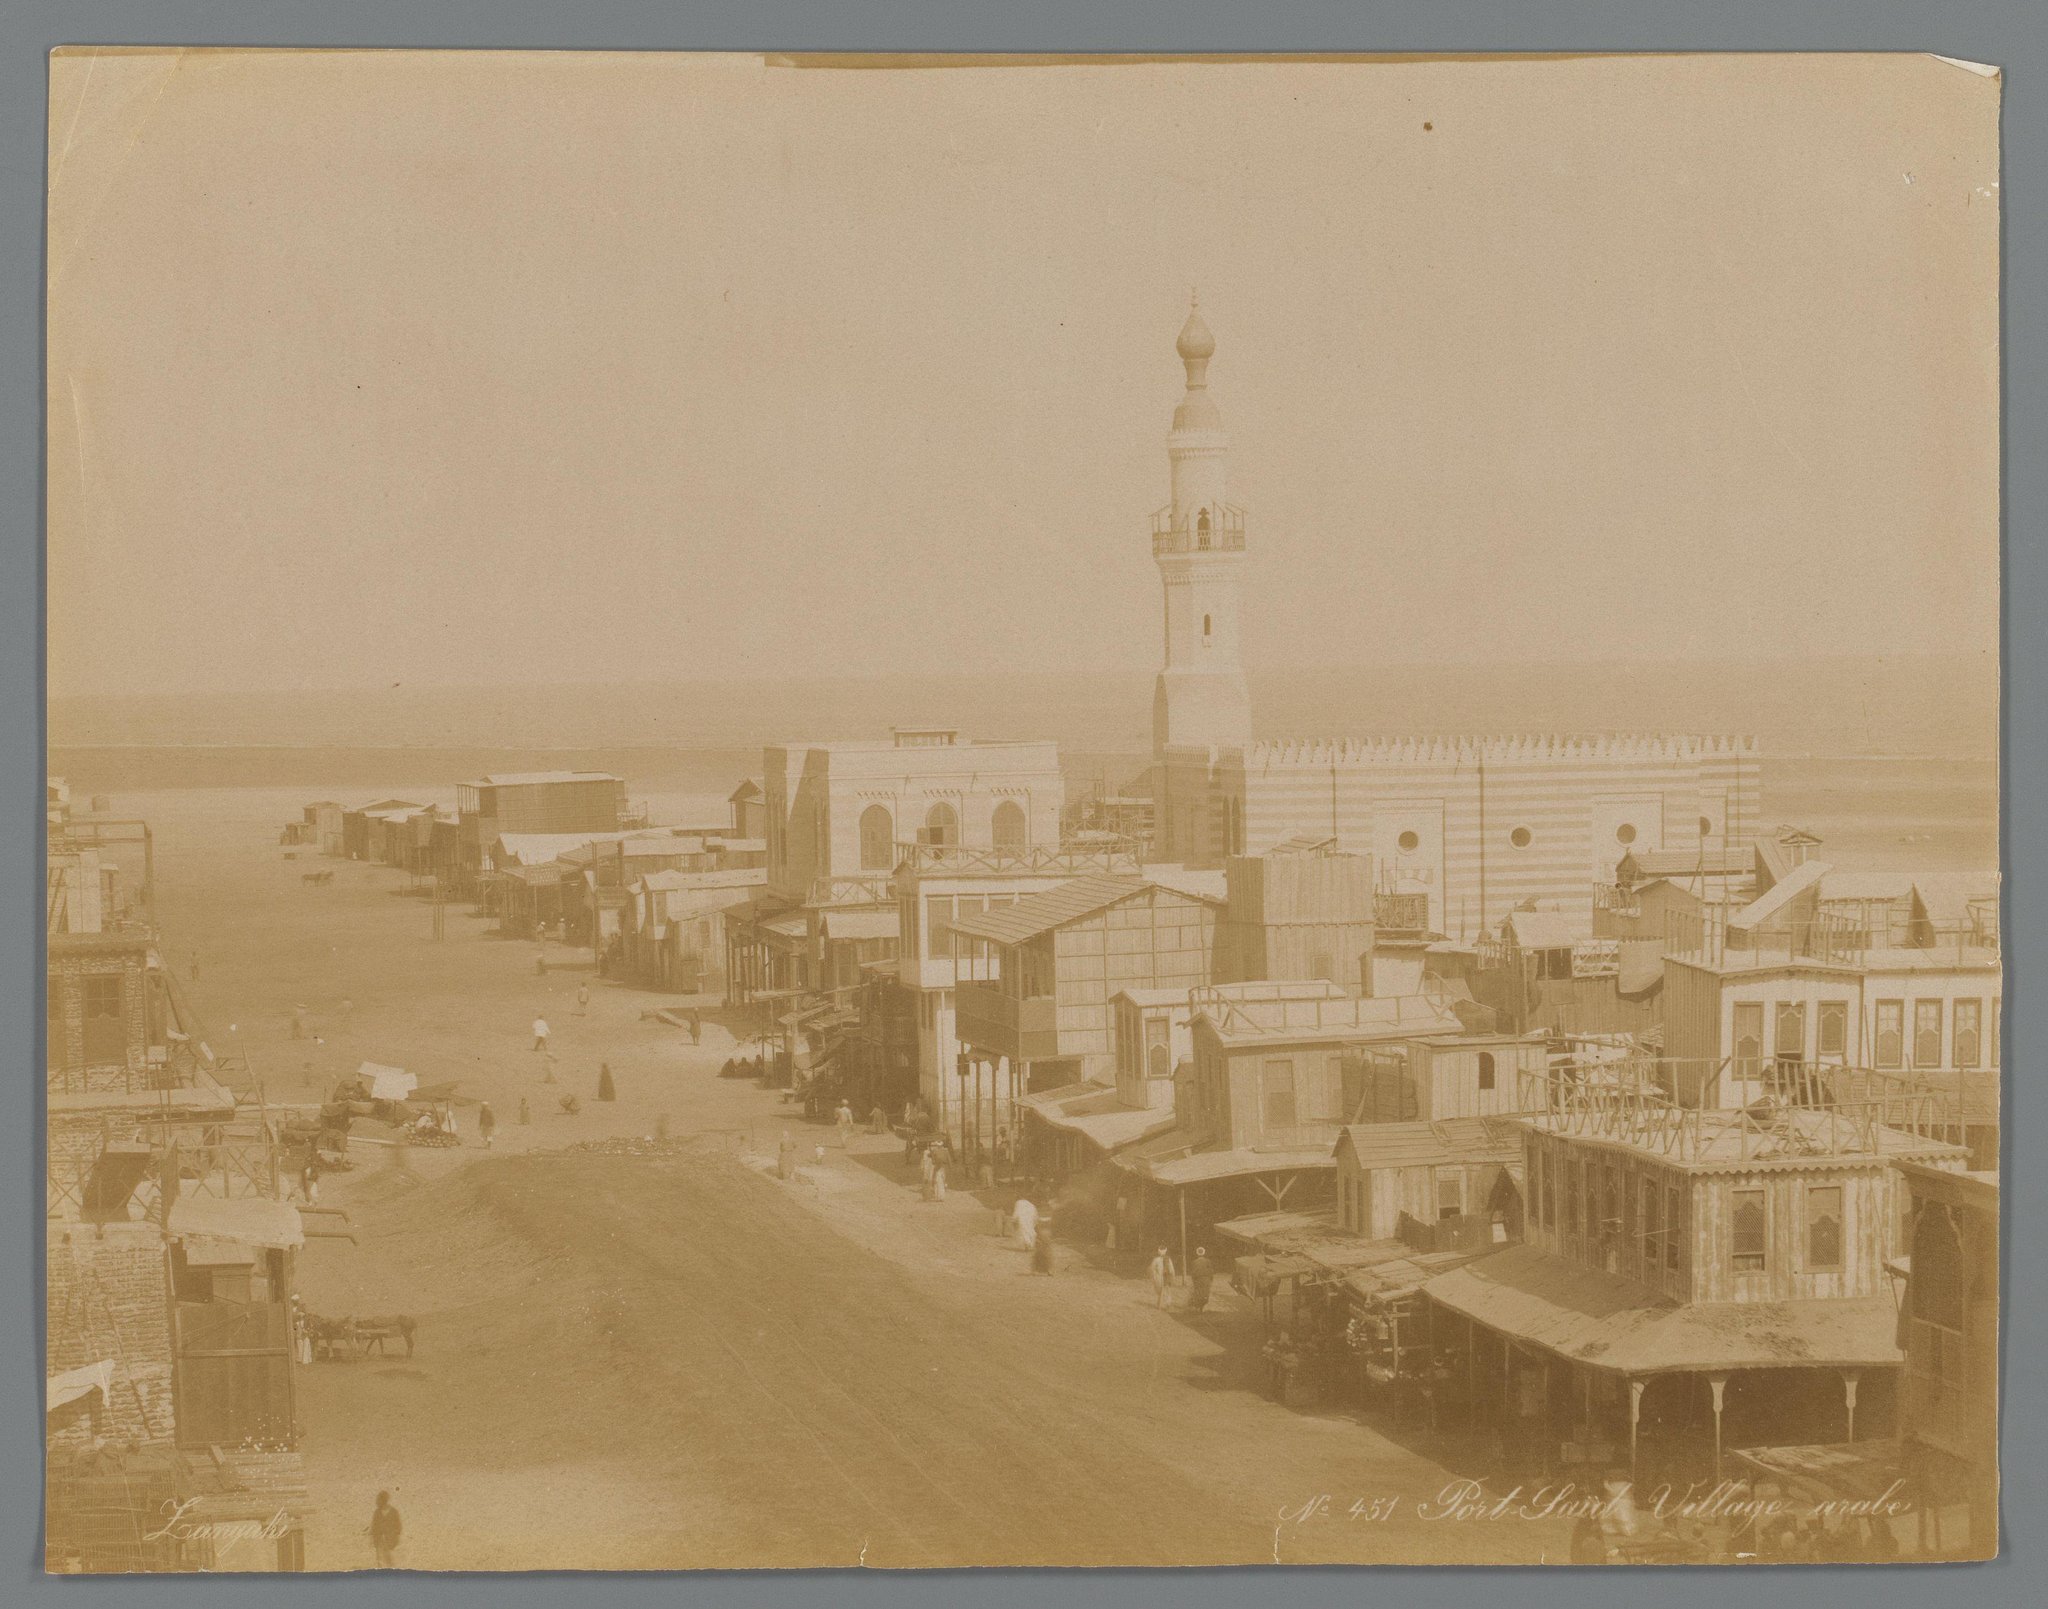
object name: photograph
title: Port Saïd, Village Arabe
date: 1870-1910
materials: paper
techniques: albumen print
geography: port said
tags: city-view in general; 'veduta', ocean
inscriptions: number: ‘No 451’